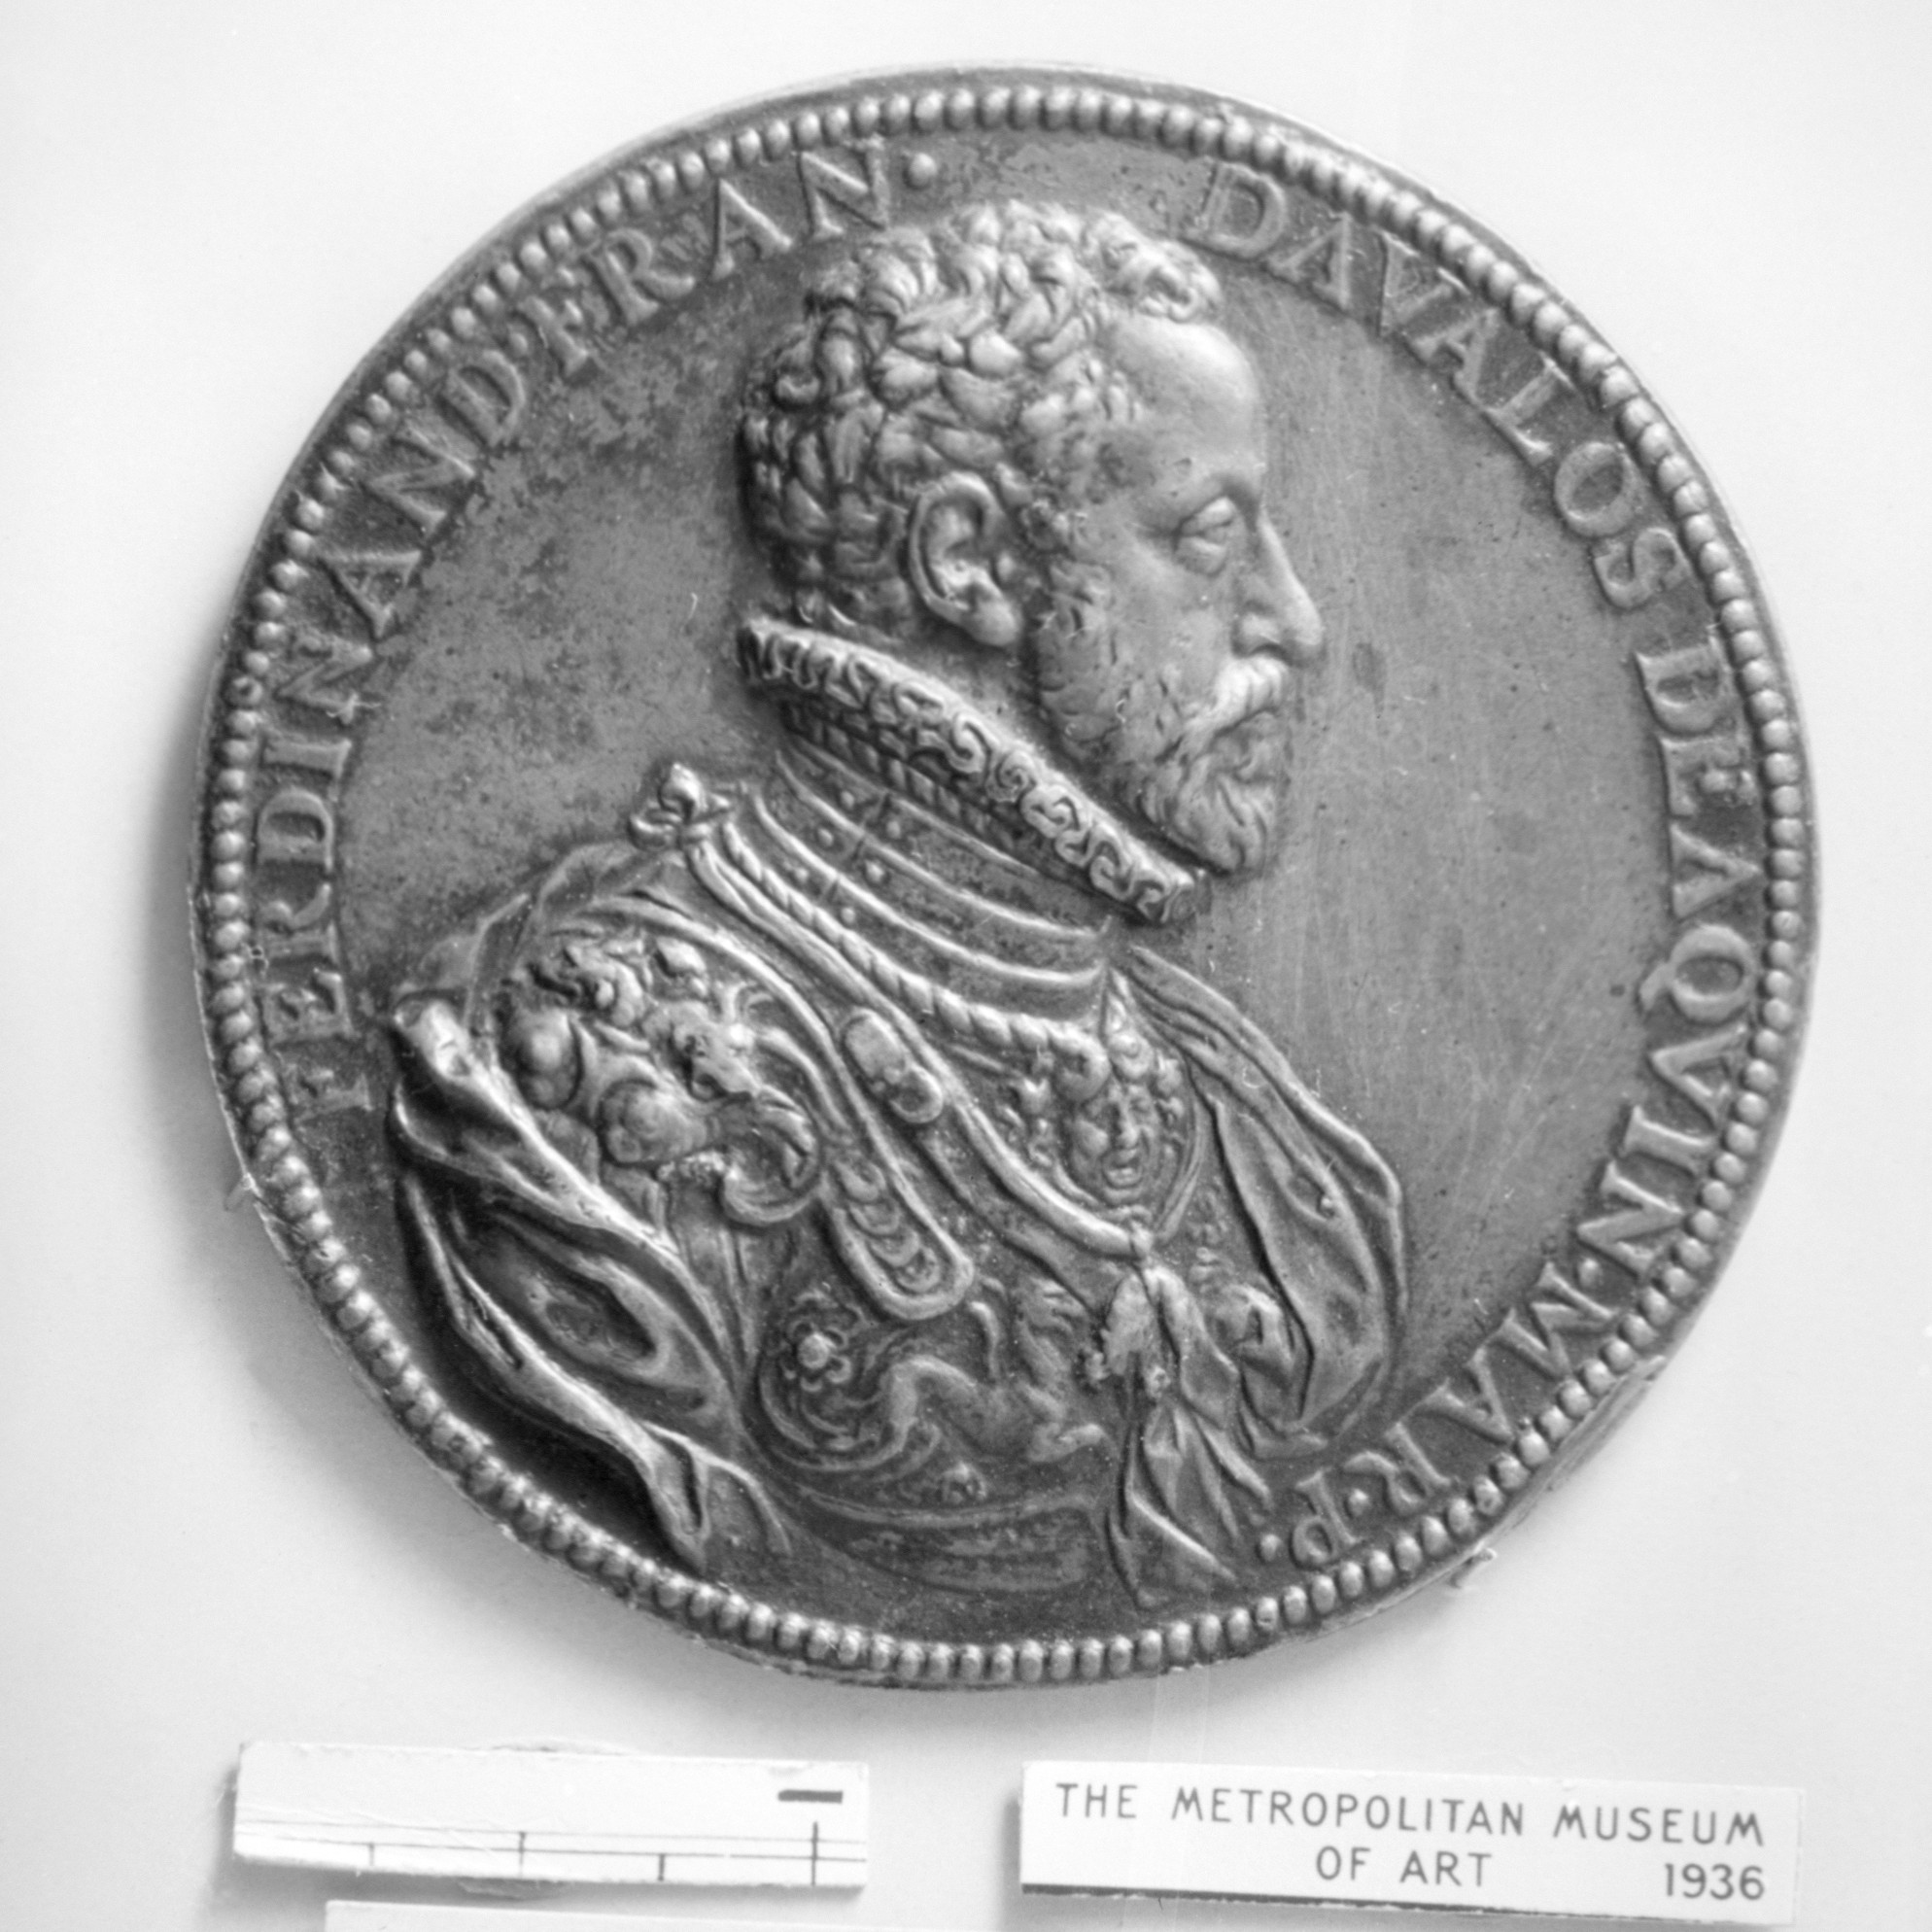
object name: medal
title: Ferdinando Francesco II d'Avalos of Aquino, Marquis of Pescara (ca. 1530–1571)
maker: annibale fontana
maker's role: artist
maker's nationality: italian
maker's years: 1540-1587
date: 1560-1570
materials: bronze, patina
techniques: casting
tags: men,profiles